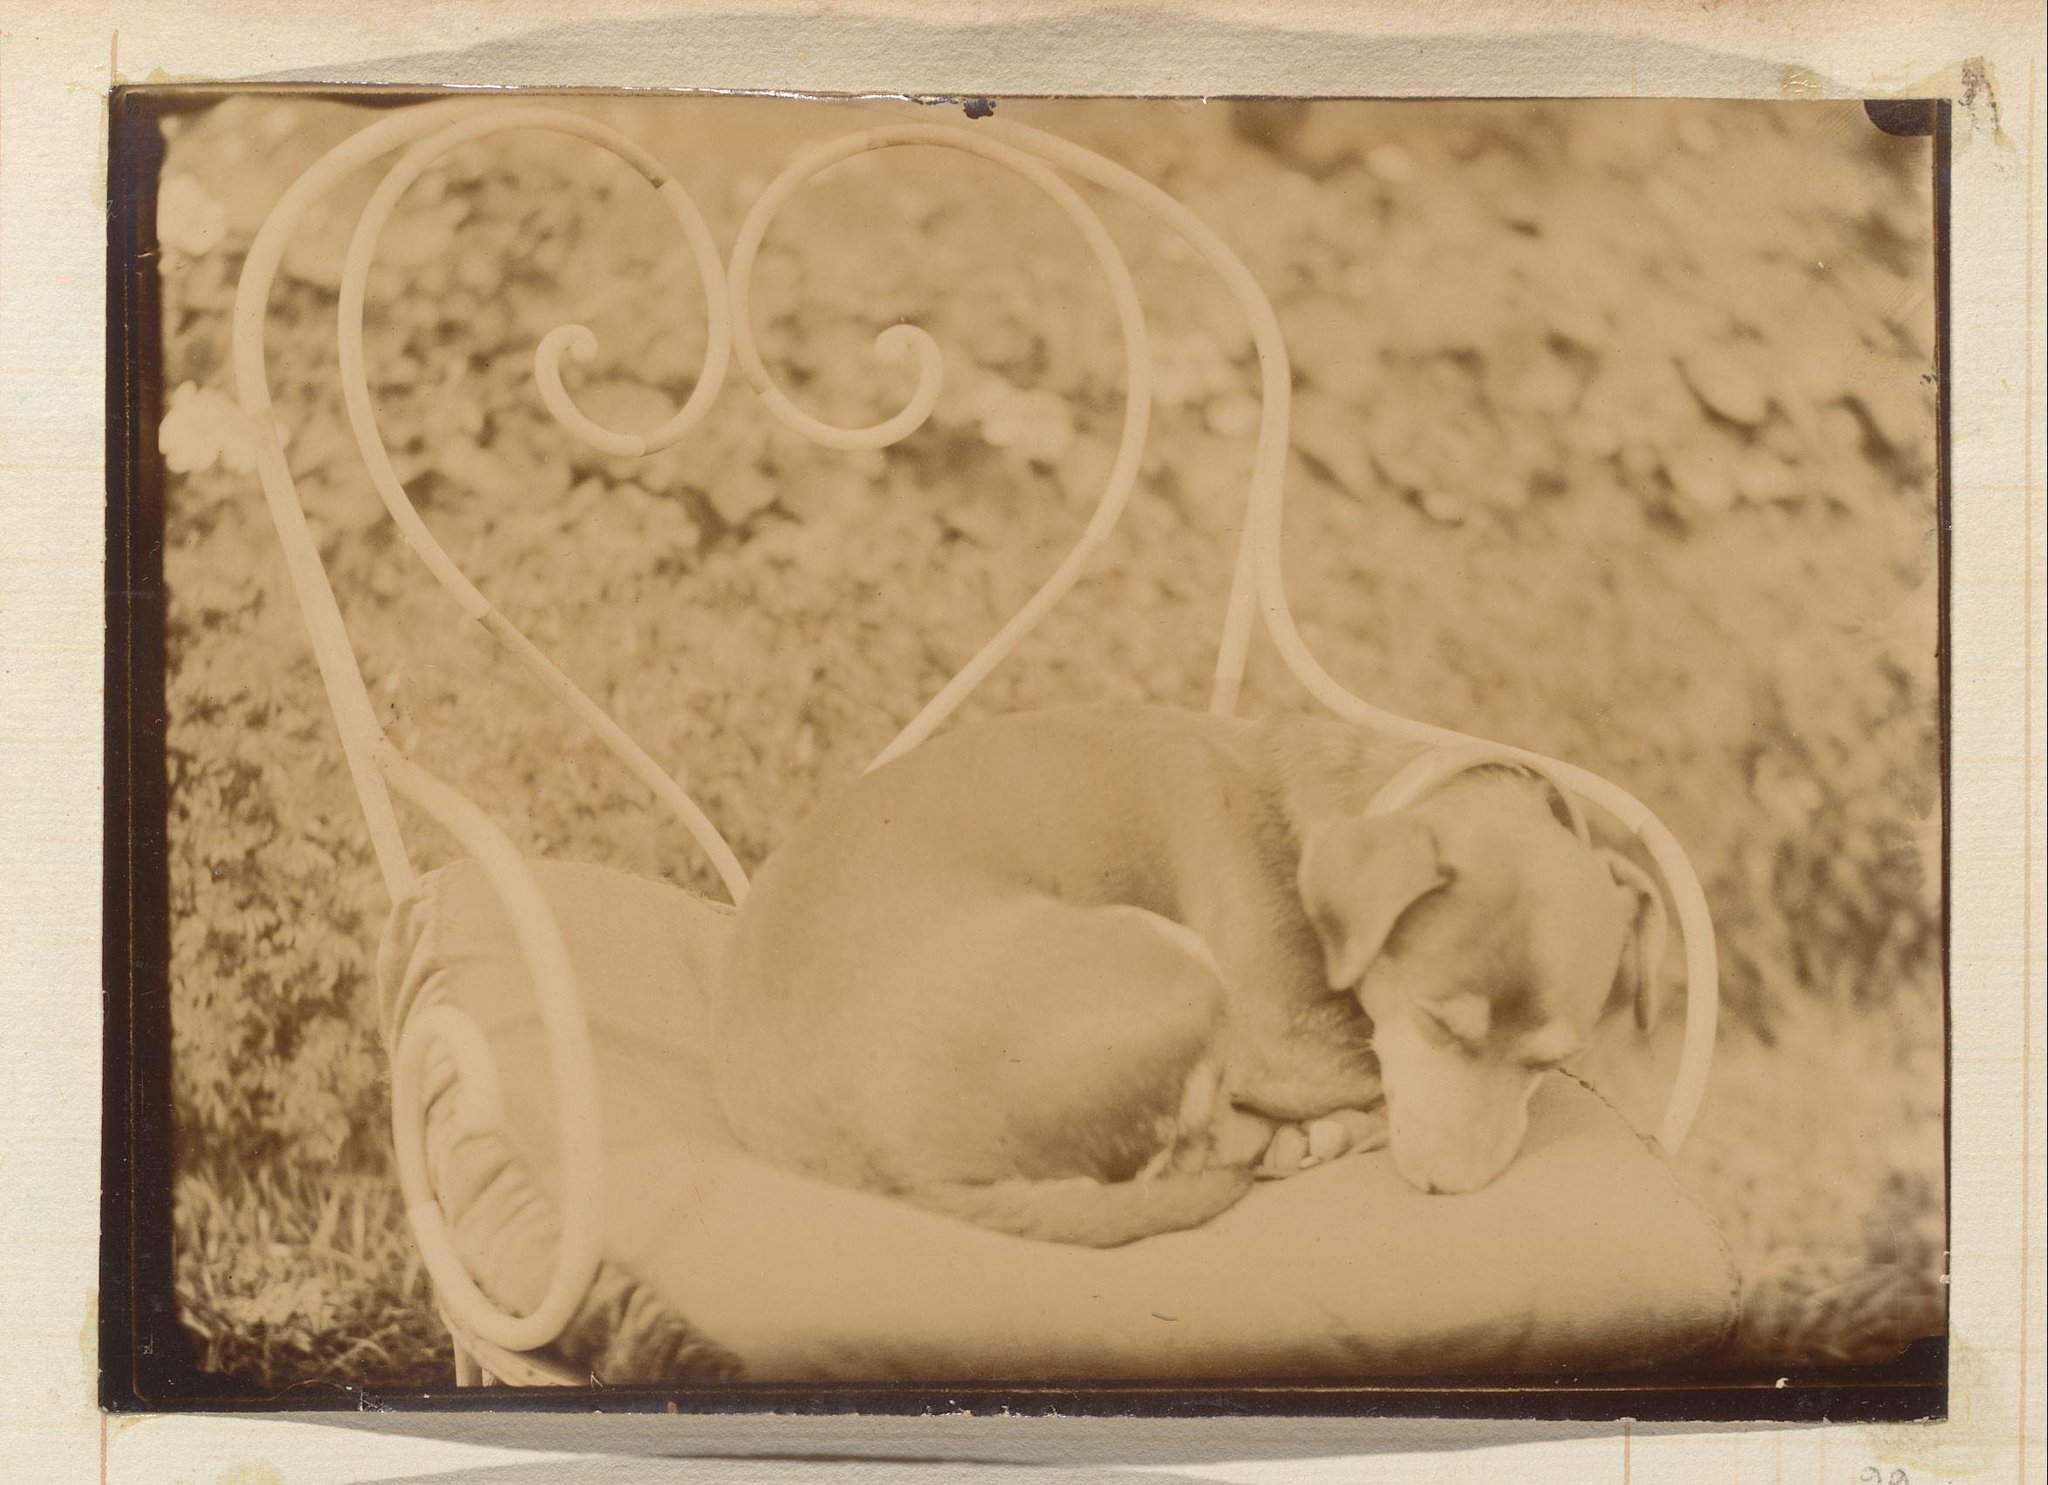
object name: photograph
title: Hond slapend op een tuinstoel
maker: Anonymous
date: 1880-1900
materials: paper, photographic support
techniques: gelatin silver print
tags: chair, dog